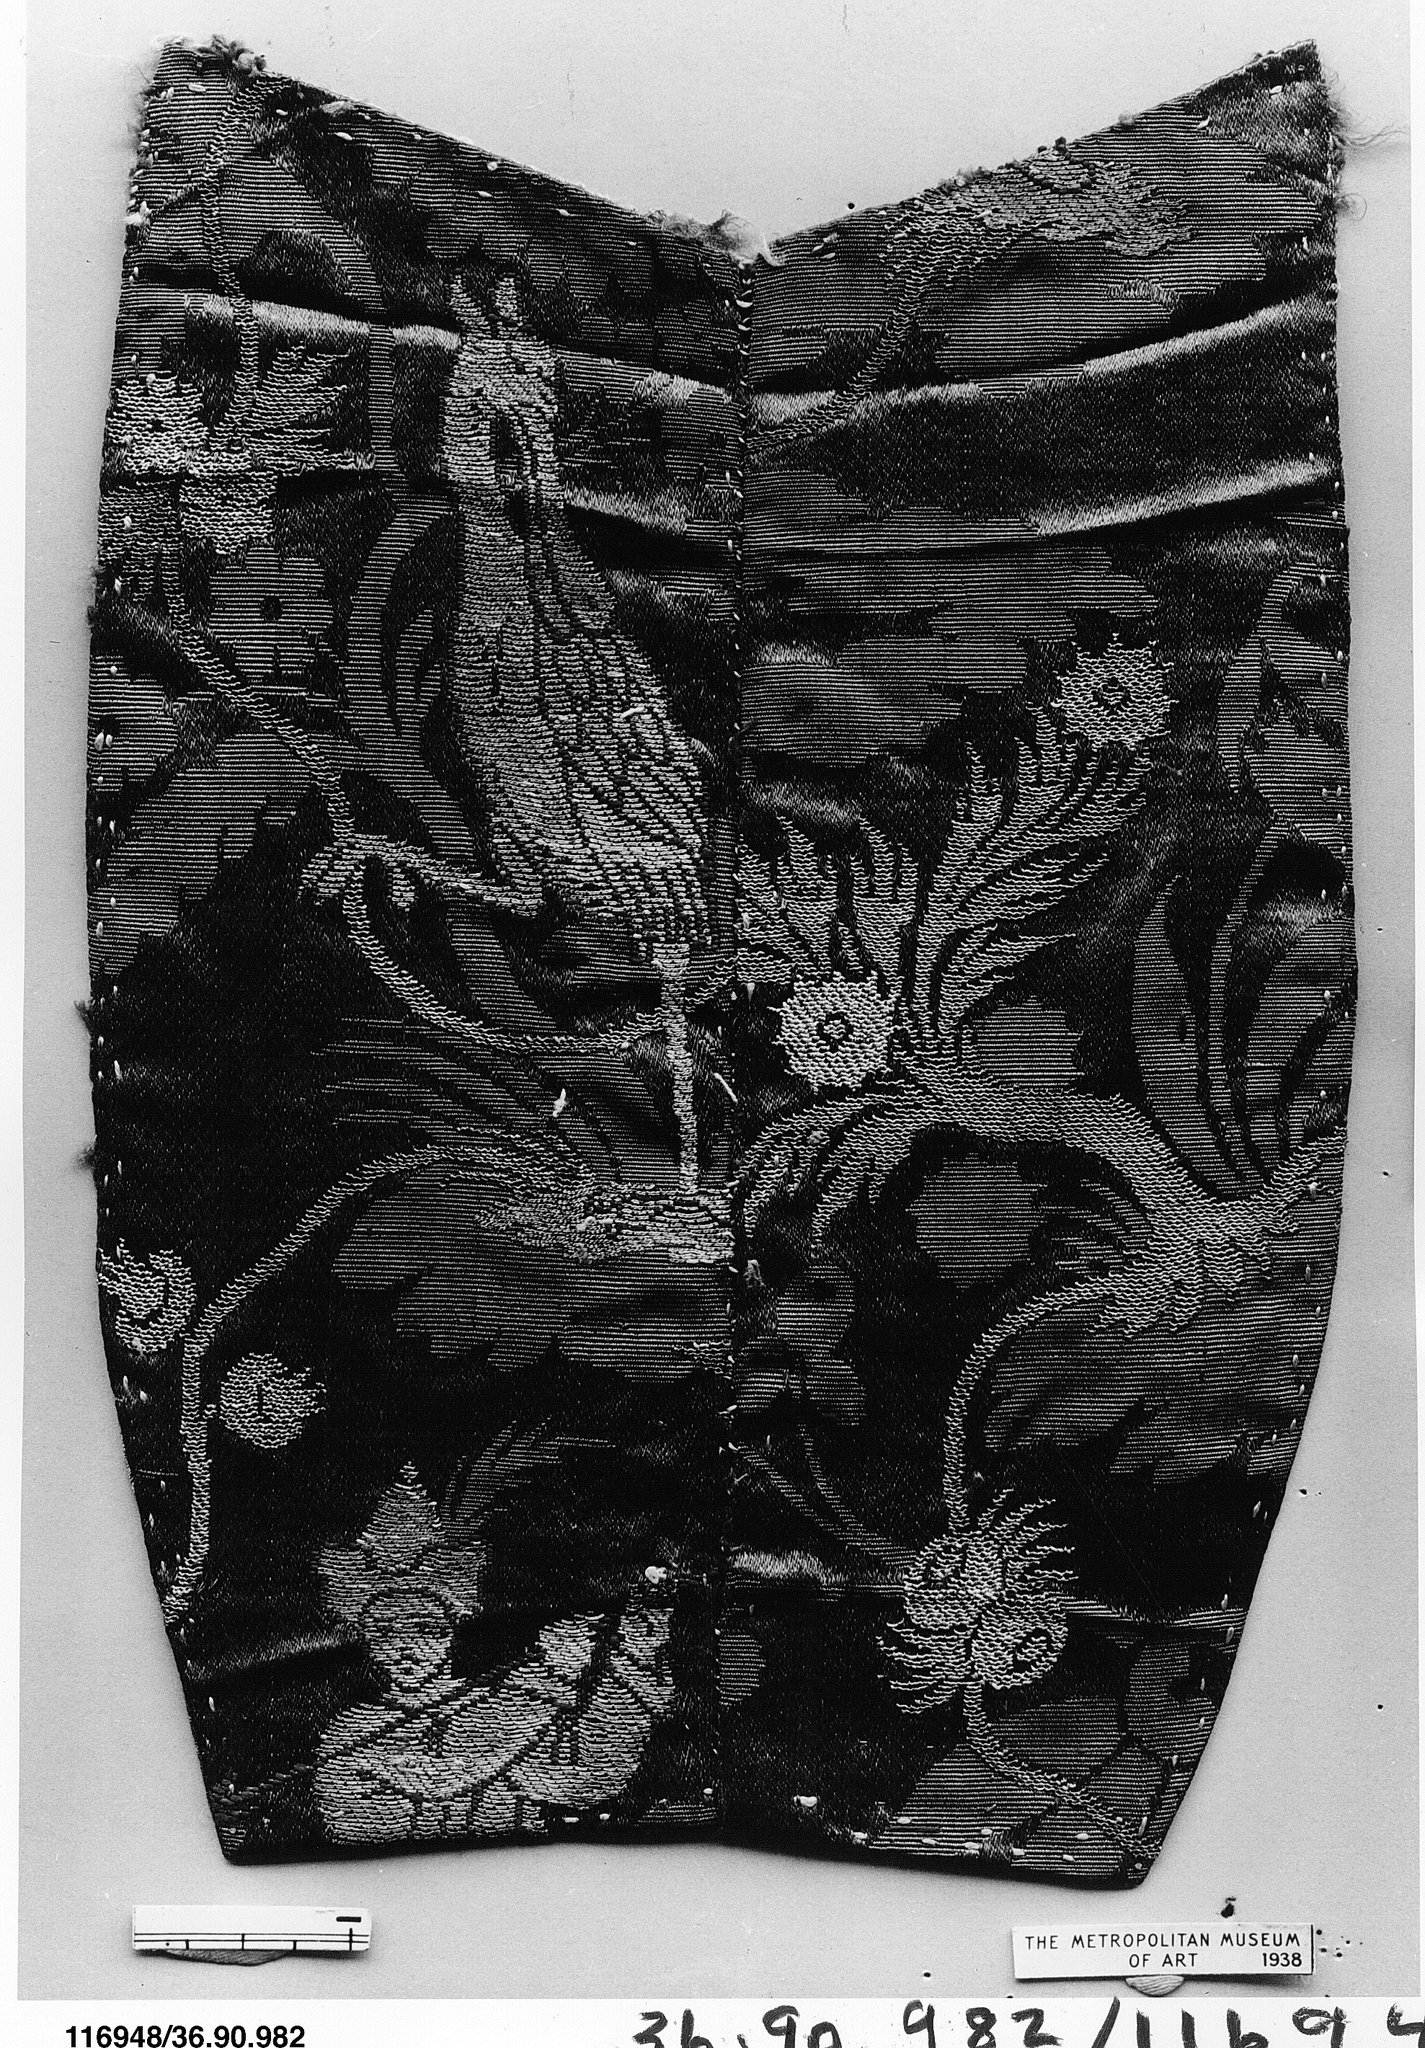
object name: piece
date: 1700-1715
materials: metal thread, silk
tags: birds,men,flowers